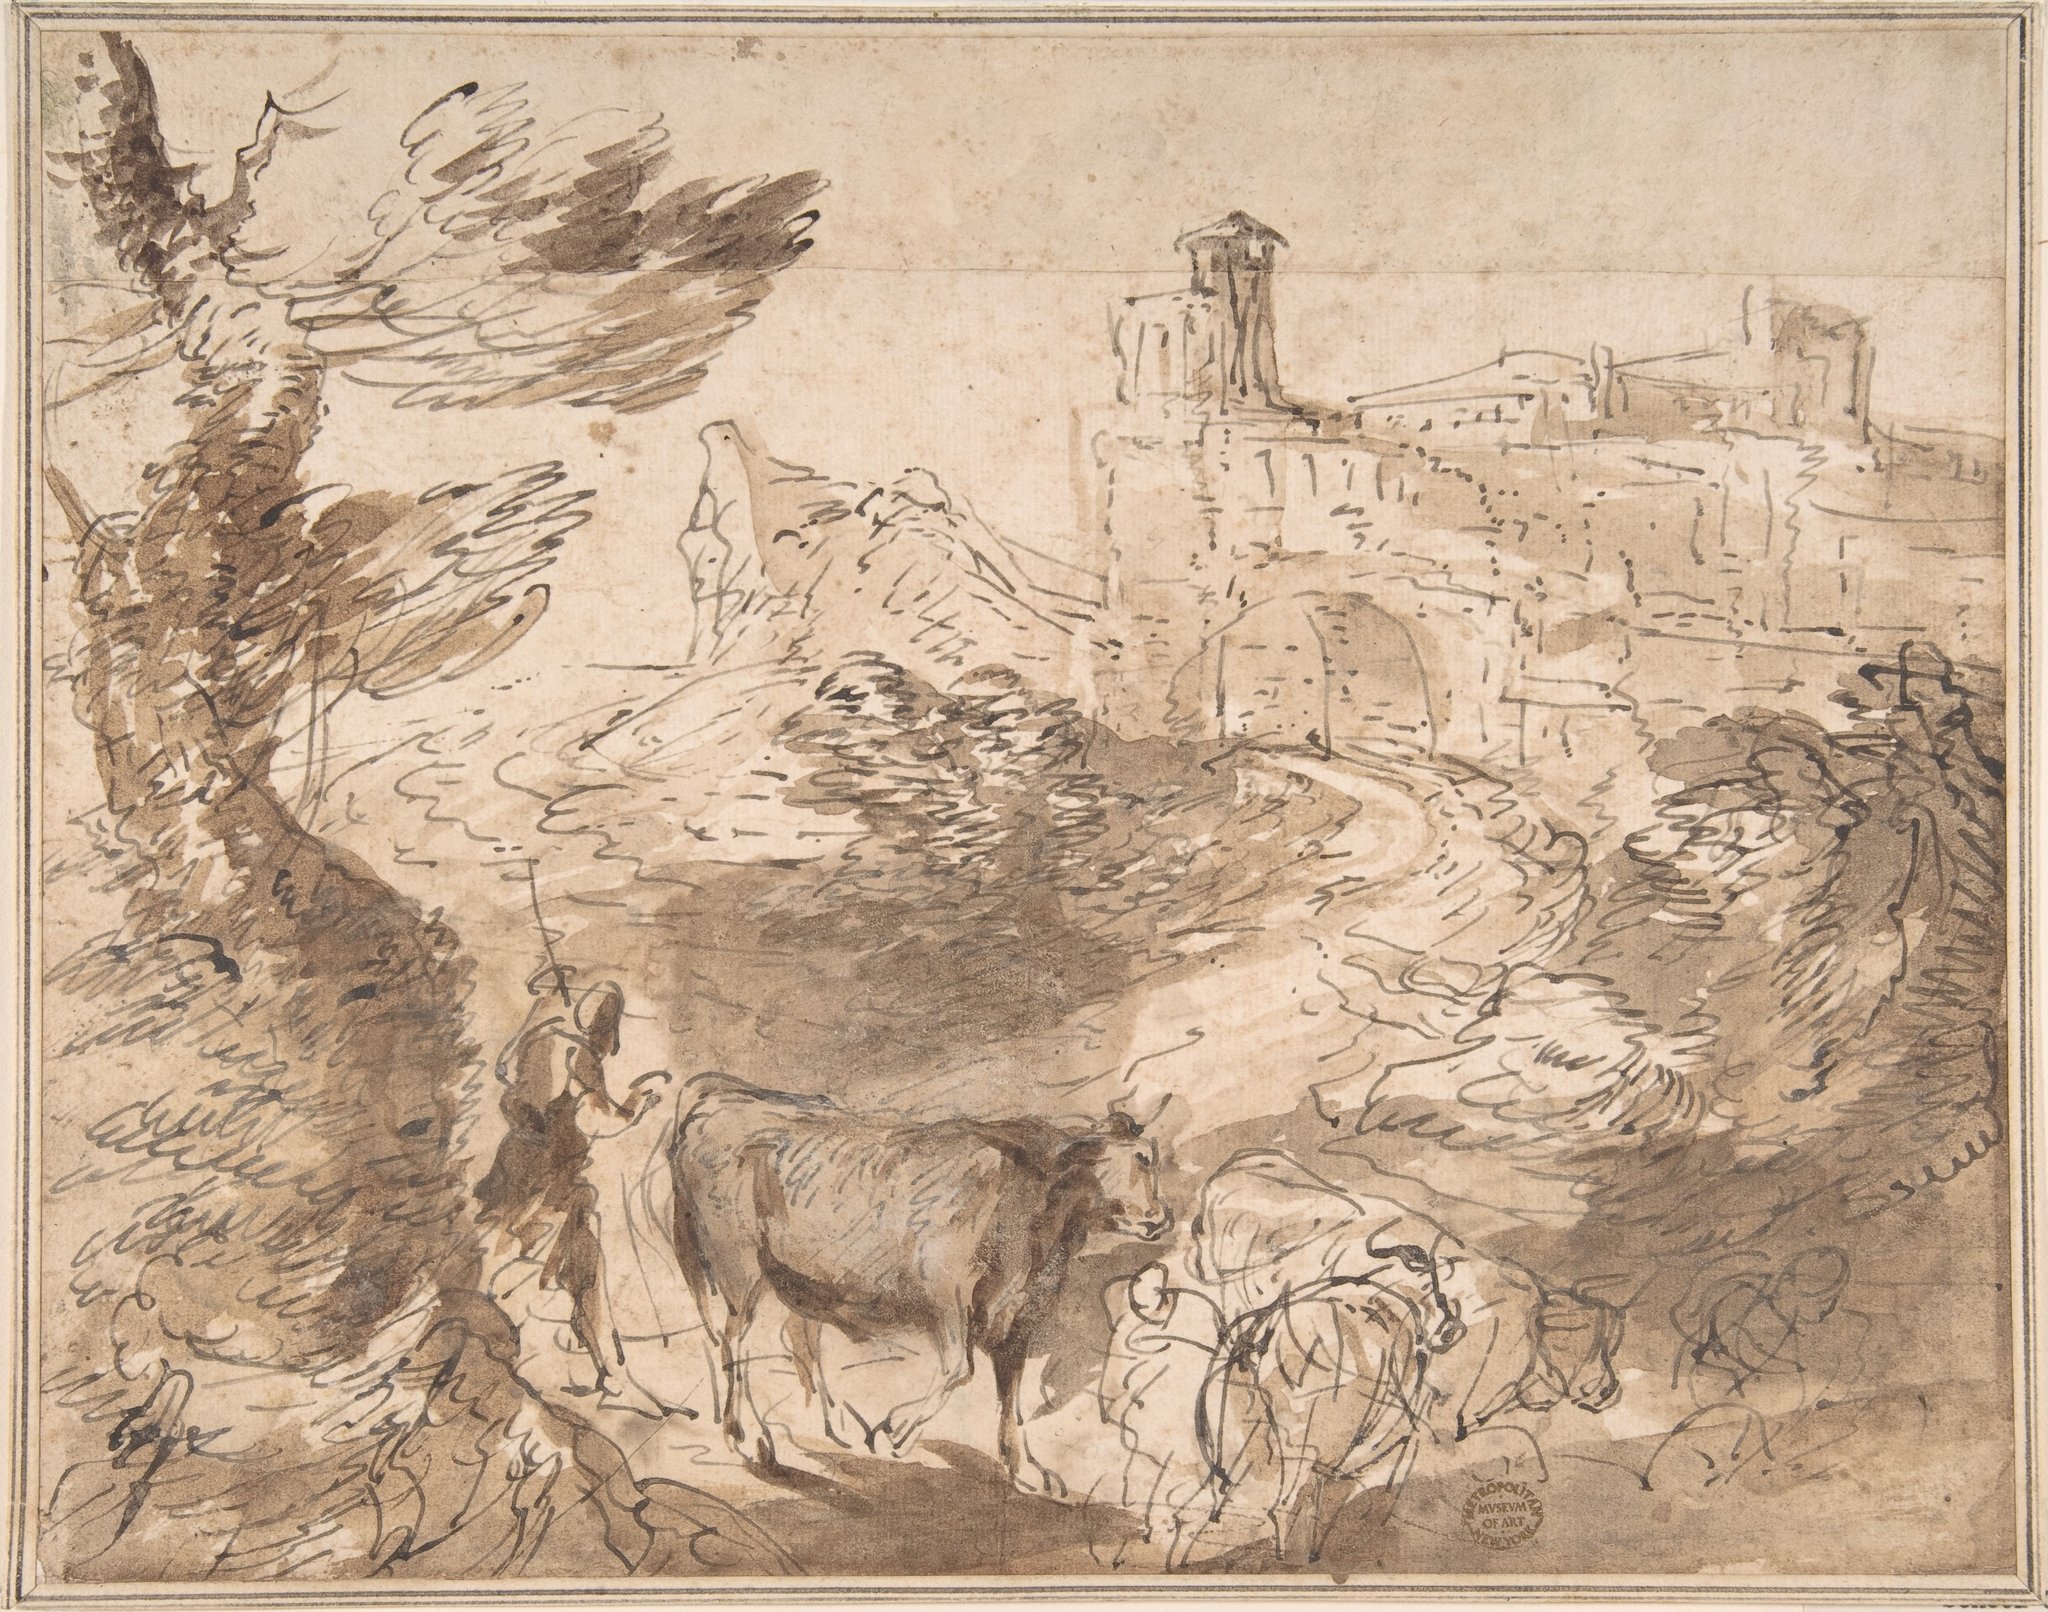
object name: drawing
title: Landscape with Herdsman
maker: anonymous, italian, roman-bolognese, 17th century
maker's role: artist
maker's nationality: italian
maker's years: 1600-1700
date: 1601-1700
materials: ink, paper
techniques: brush, pen, wash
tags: men,cows,landscapes